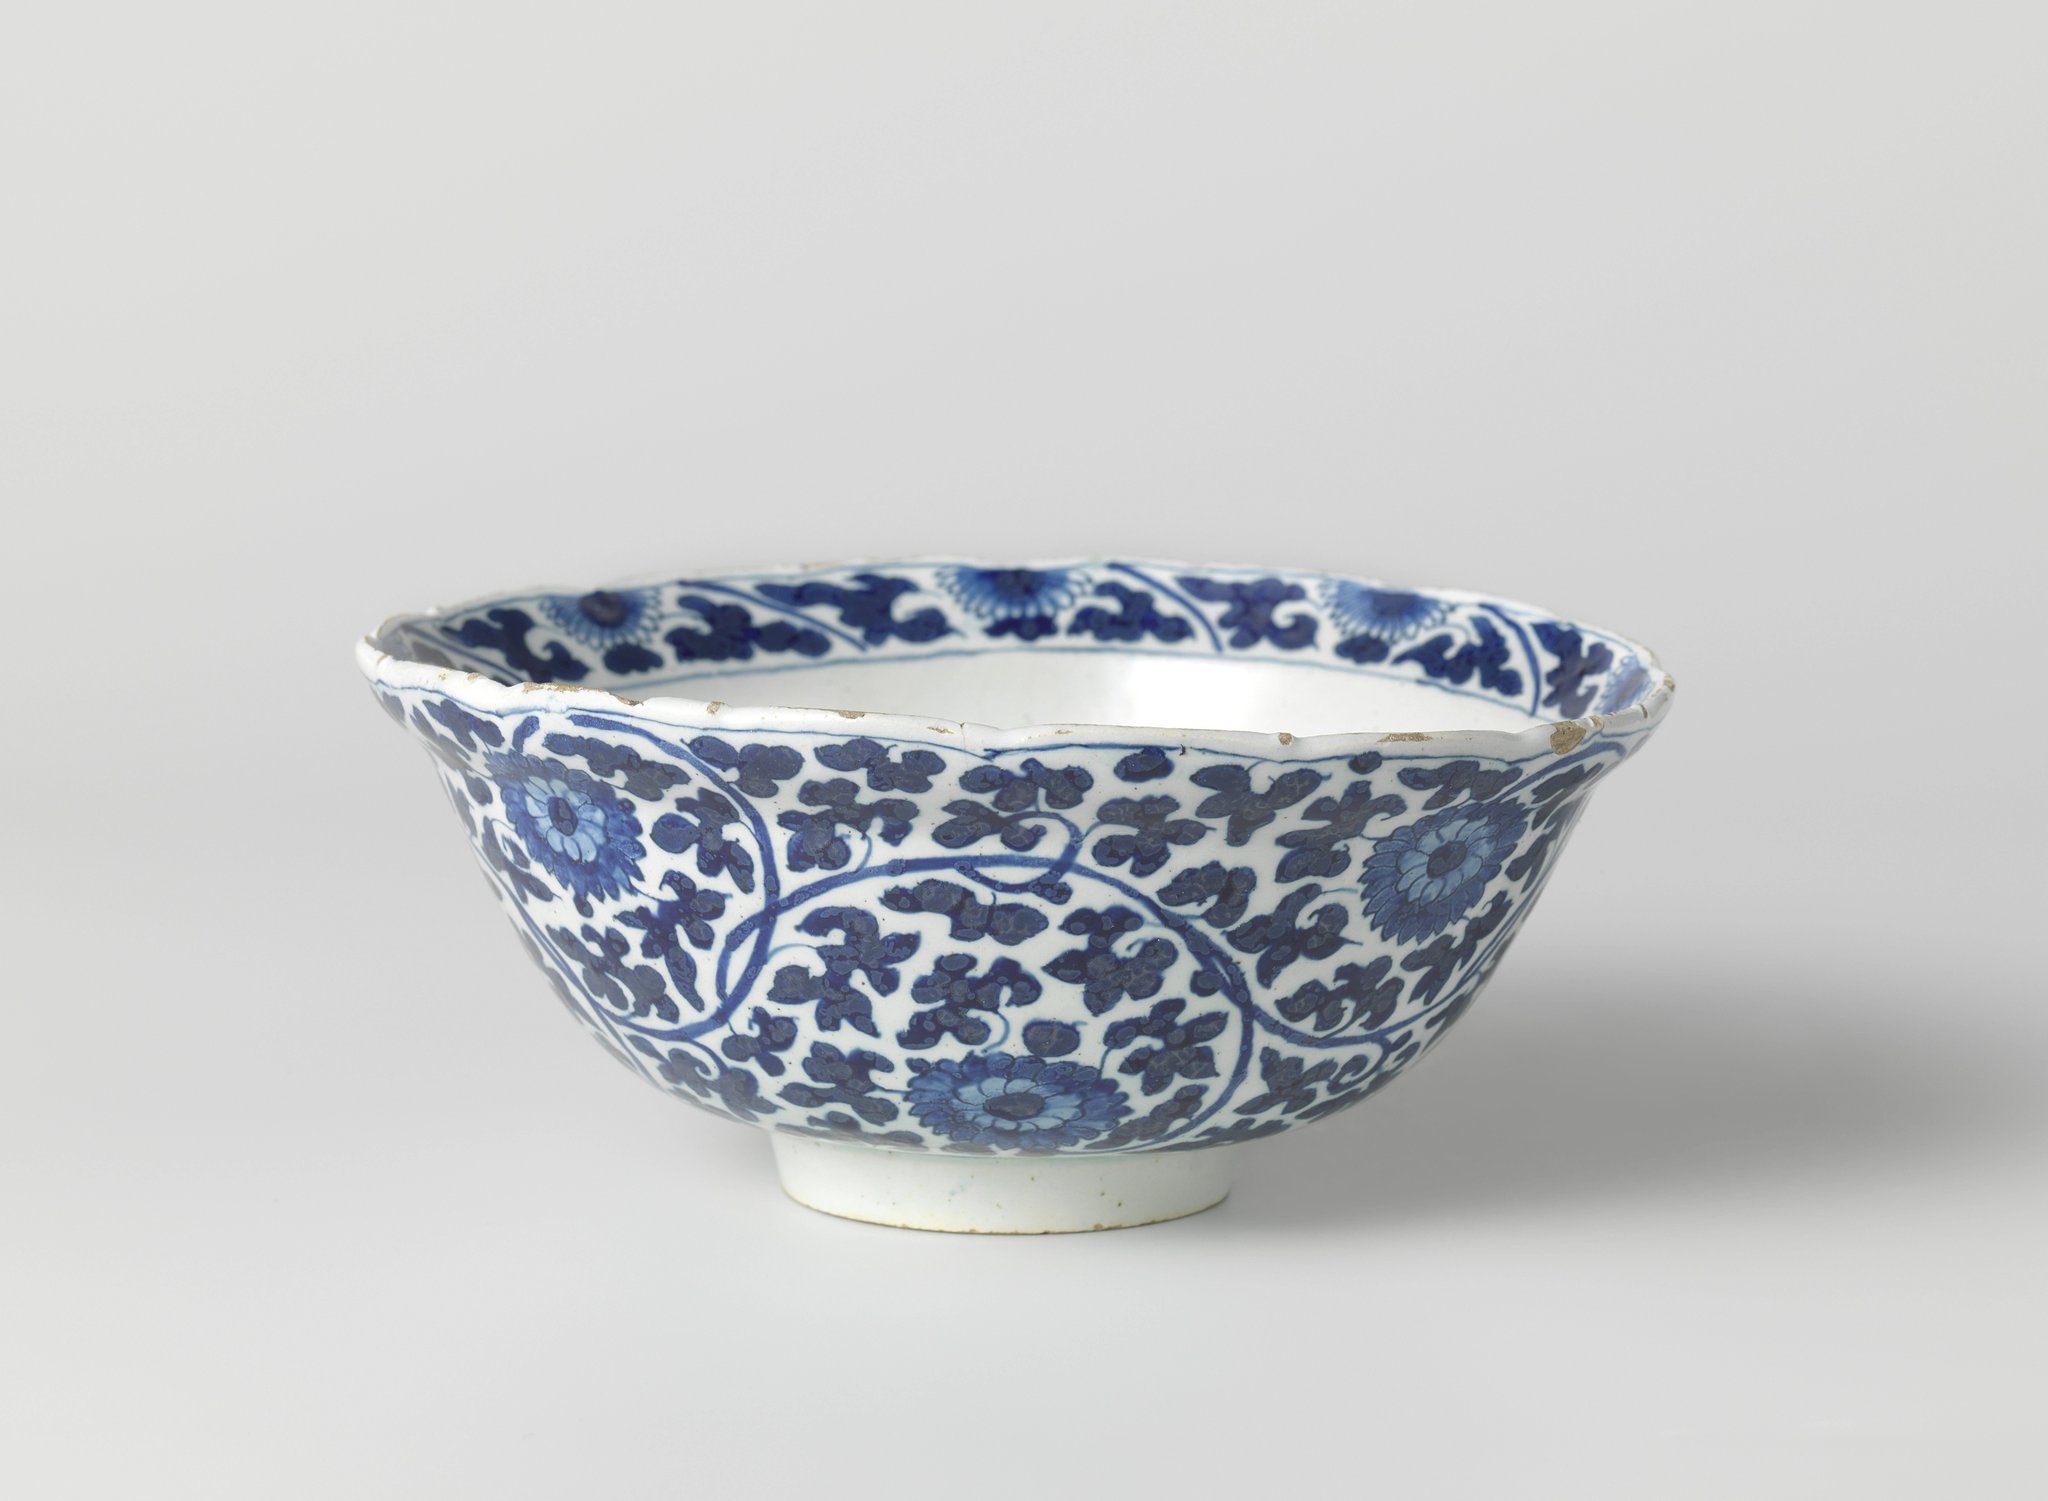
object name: bowl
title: Kom met 'tigerlilly'-patroon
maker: lambertus van eenhoorn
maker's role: plateelbakker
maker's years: 1651-1721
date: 1691-1724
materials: faience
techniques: painted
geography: delft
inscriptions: mark: ‘LVE(ineen)/ 6 A/ 2(?) onleesbaar door zegel’, seal: ‘koninklijk oudheidkundig genootschap no. 5[...]’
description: Kom van faience, geheel met witte tinglazuur, blauw beschilderd met het 'tigerlilly'-patroon. Op de onderzijde gemerkt.